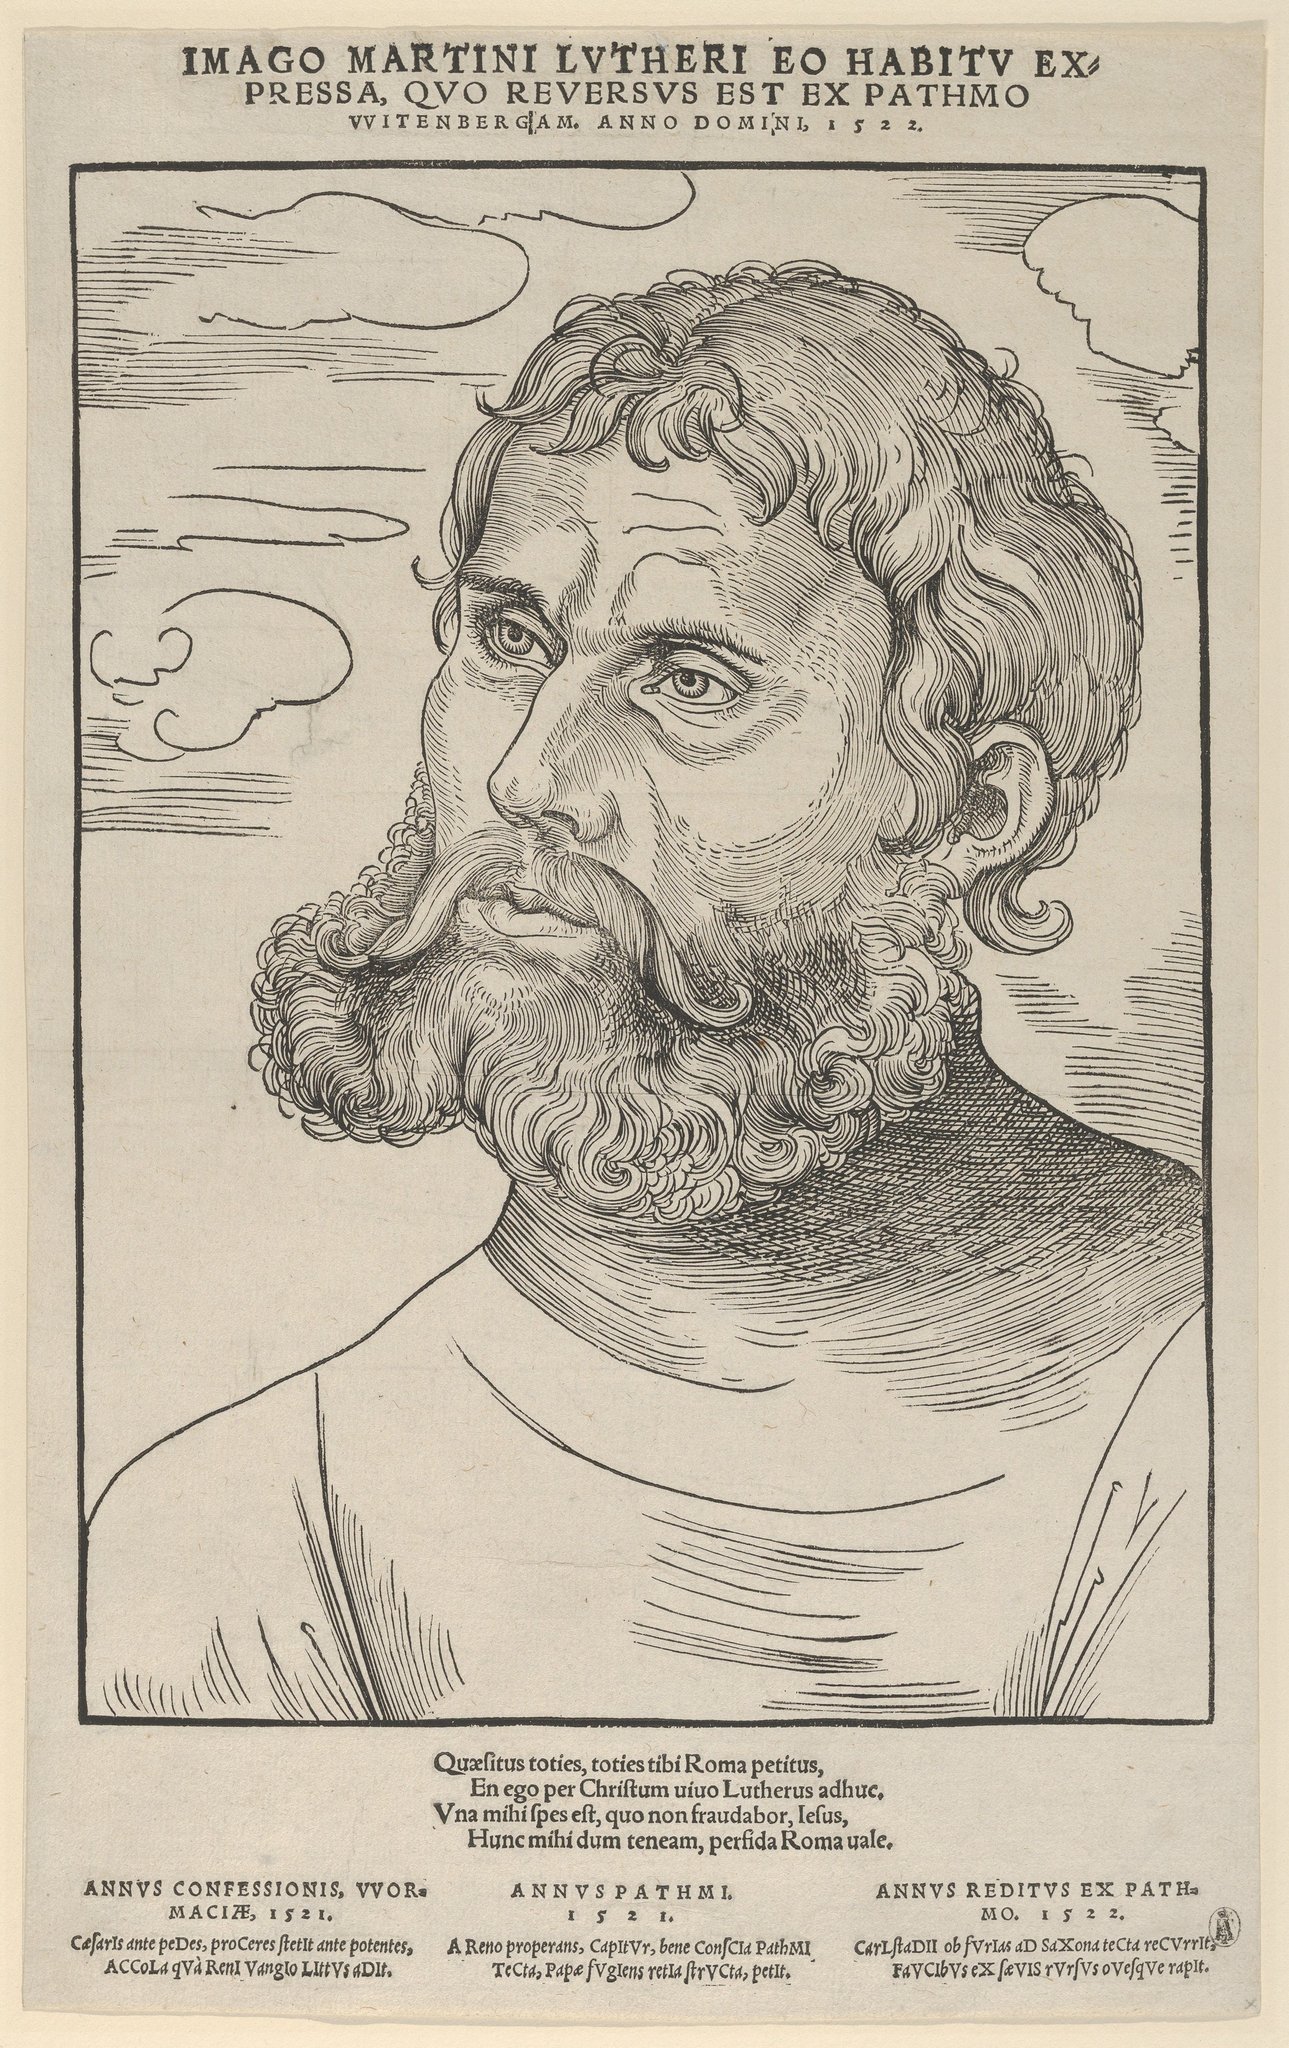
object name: print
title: Luther as 'Junker Jorg'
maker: lucas cranach the elder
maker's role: artist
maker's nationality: german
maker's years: 1472-1553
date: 1522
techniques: woodcut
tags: martin luther,men